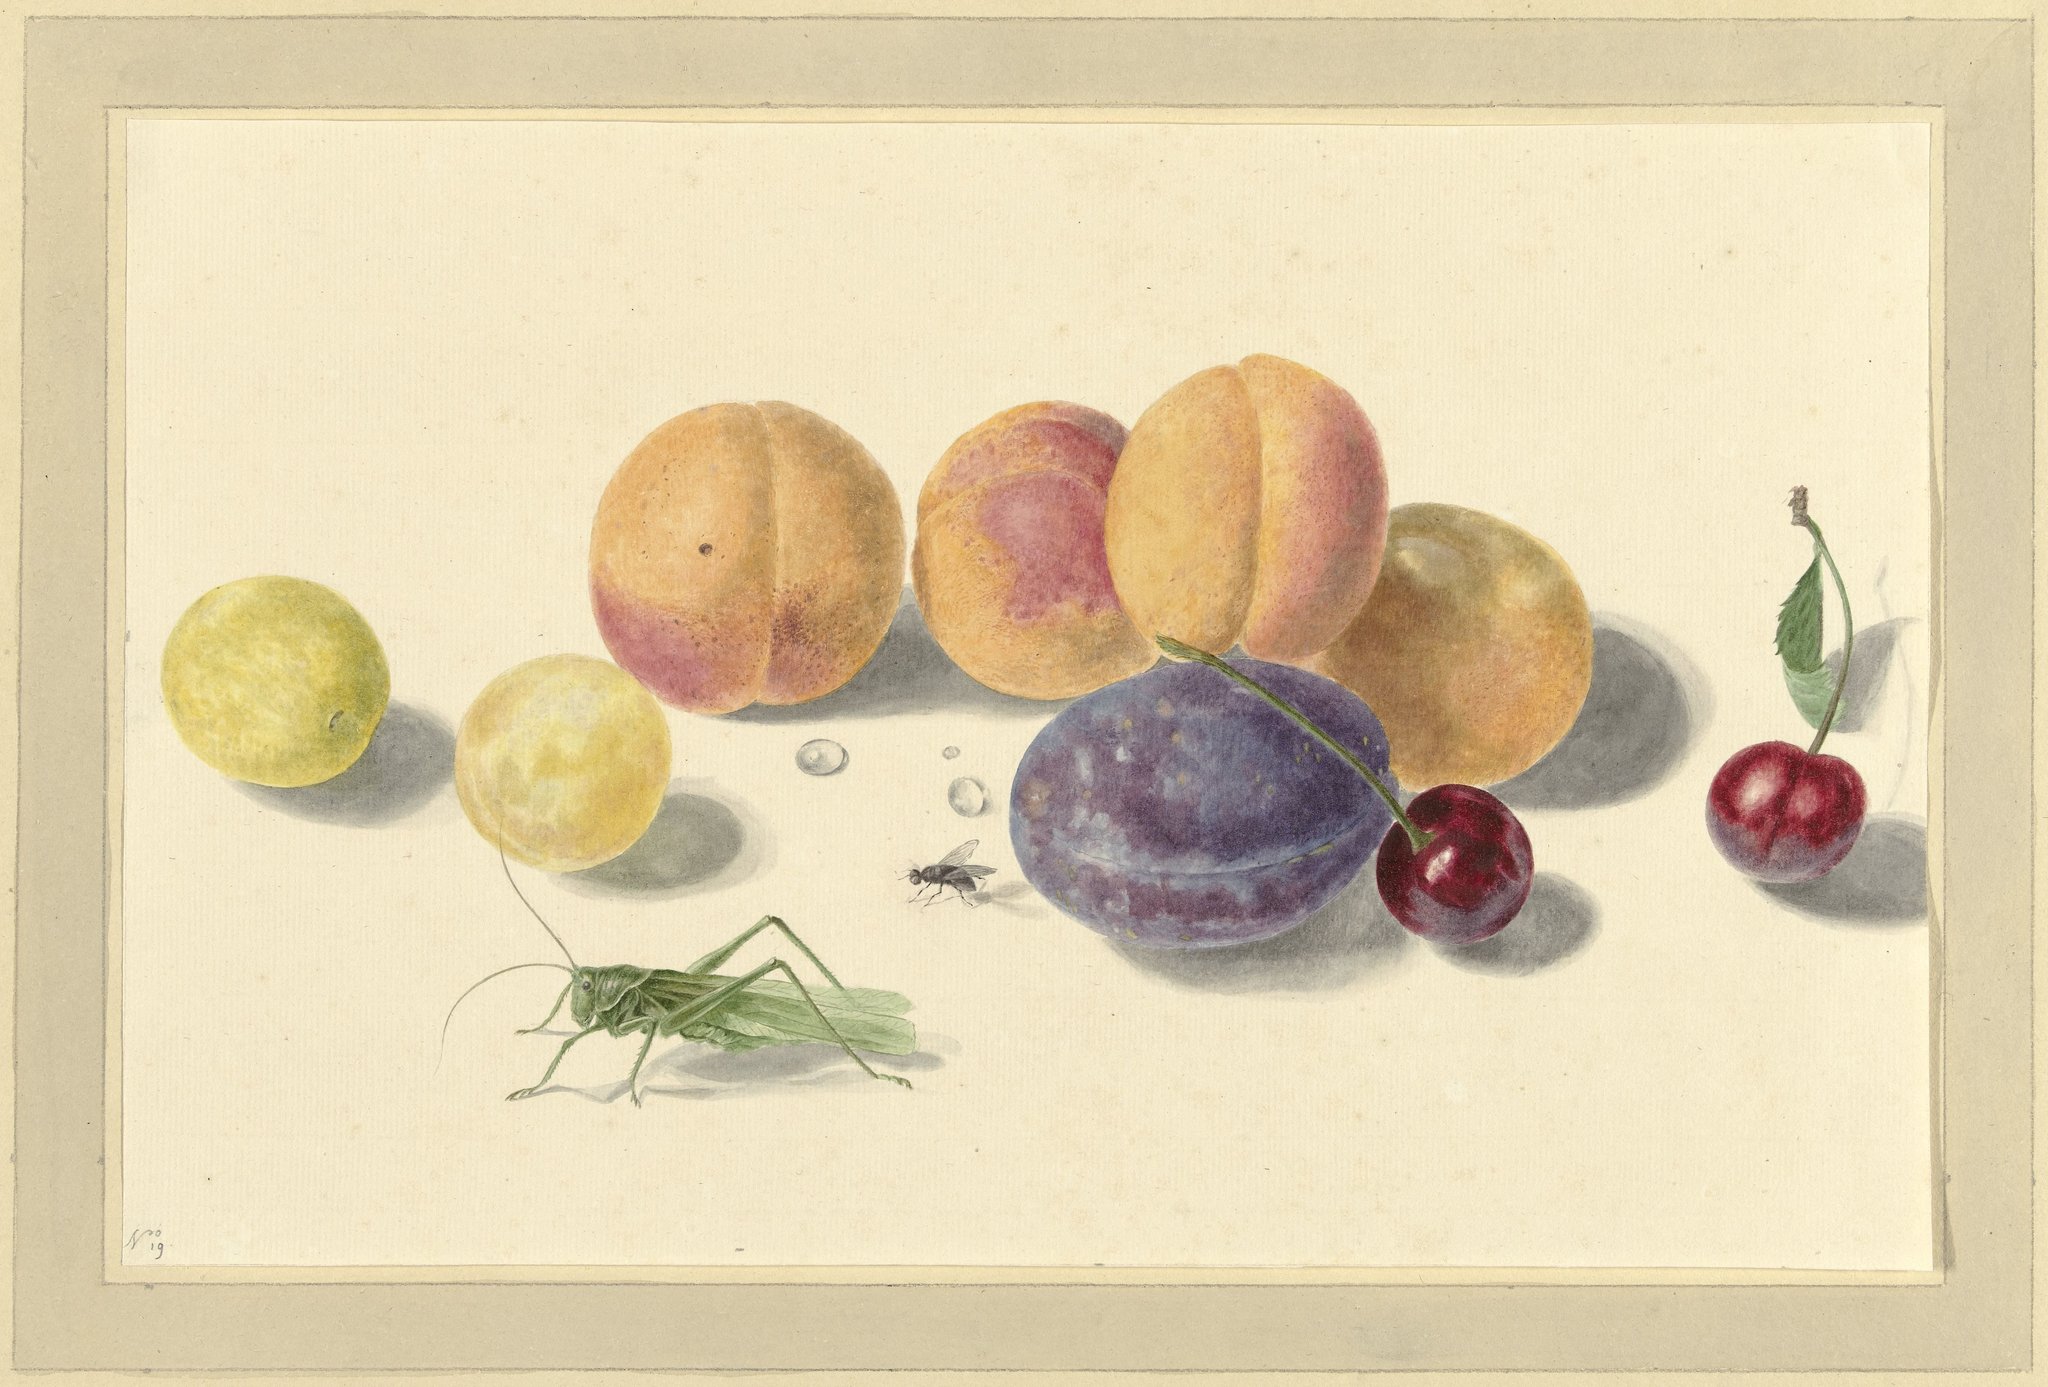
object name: drawing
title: Perziken, pruimen, kersen en twee insecten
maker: elisabeth geertruida van de kasteele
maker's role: draughtsman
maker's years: 1808-1853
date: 1818-1853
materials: paper, pencil, watercolor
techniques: brush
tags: fruits: plum, fruit, fruits: cherry, fruits: peach